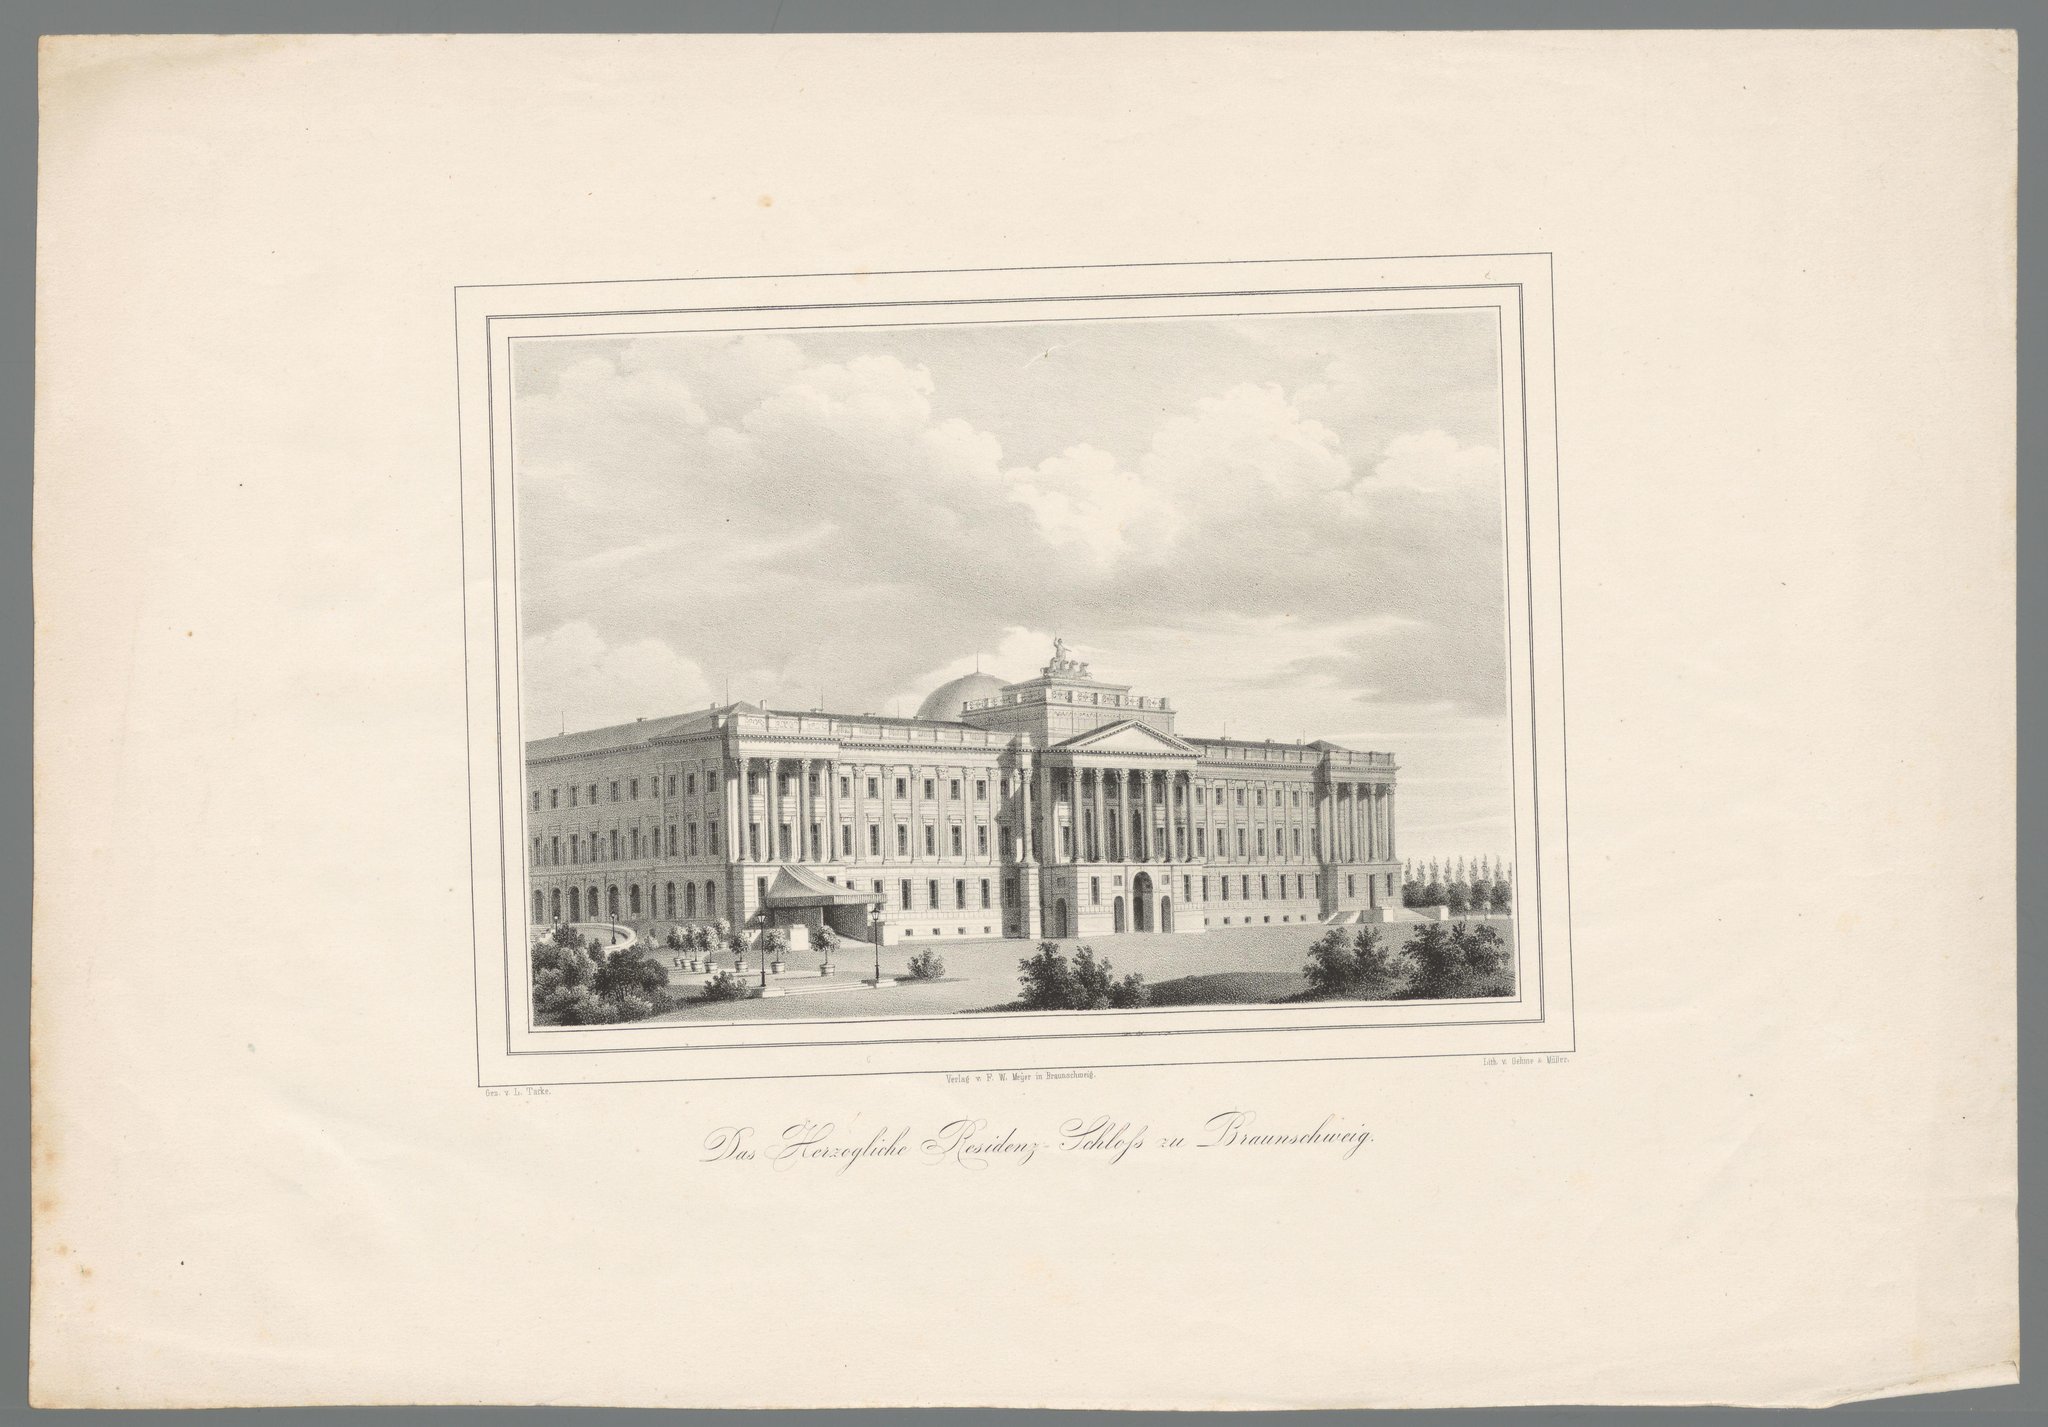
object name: print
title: Gezicht op het Braunschweiger Schloss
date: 1825-1850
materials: paper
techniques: lithograph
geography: braunschweig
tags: palace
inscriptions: collector's mark: Lugt 2228